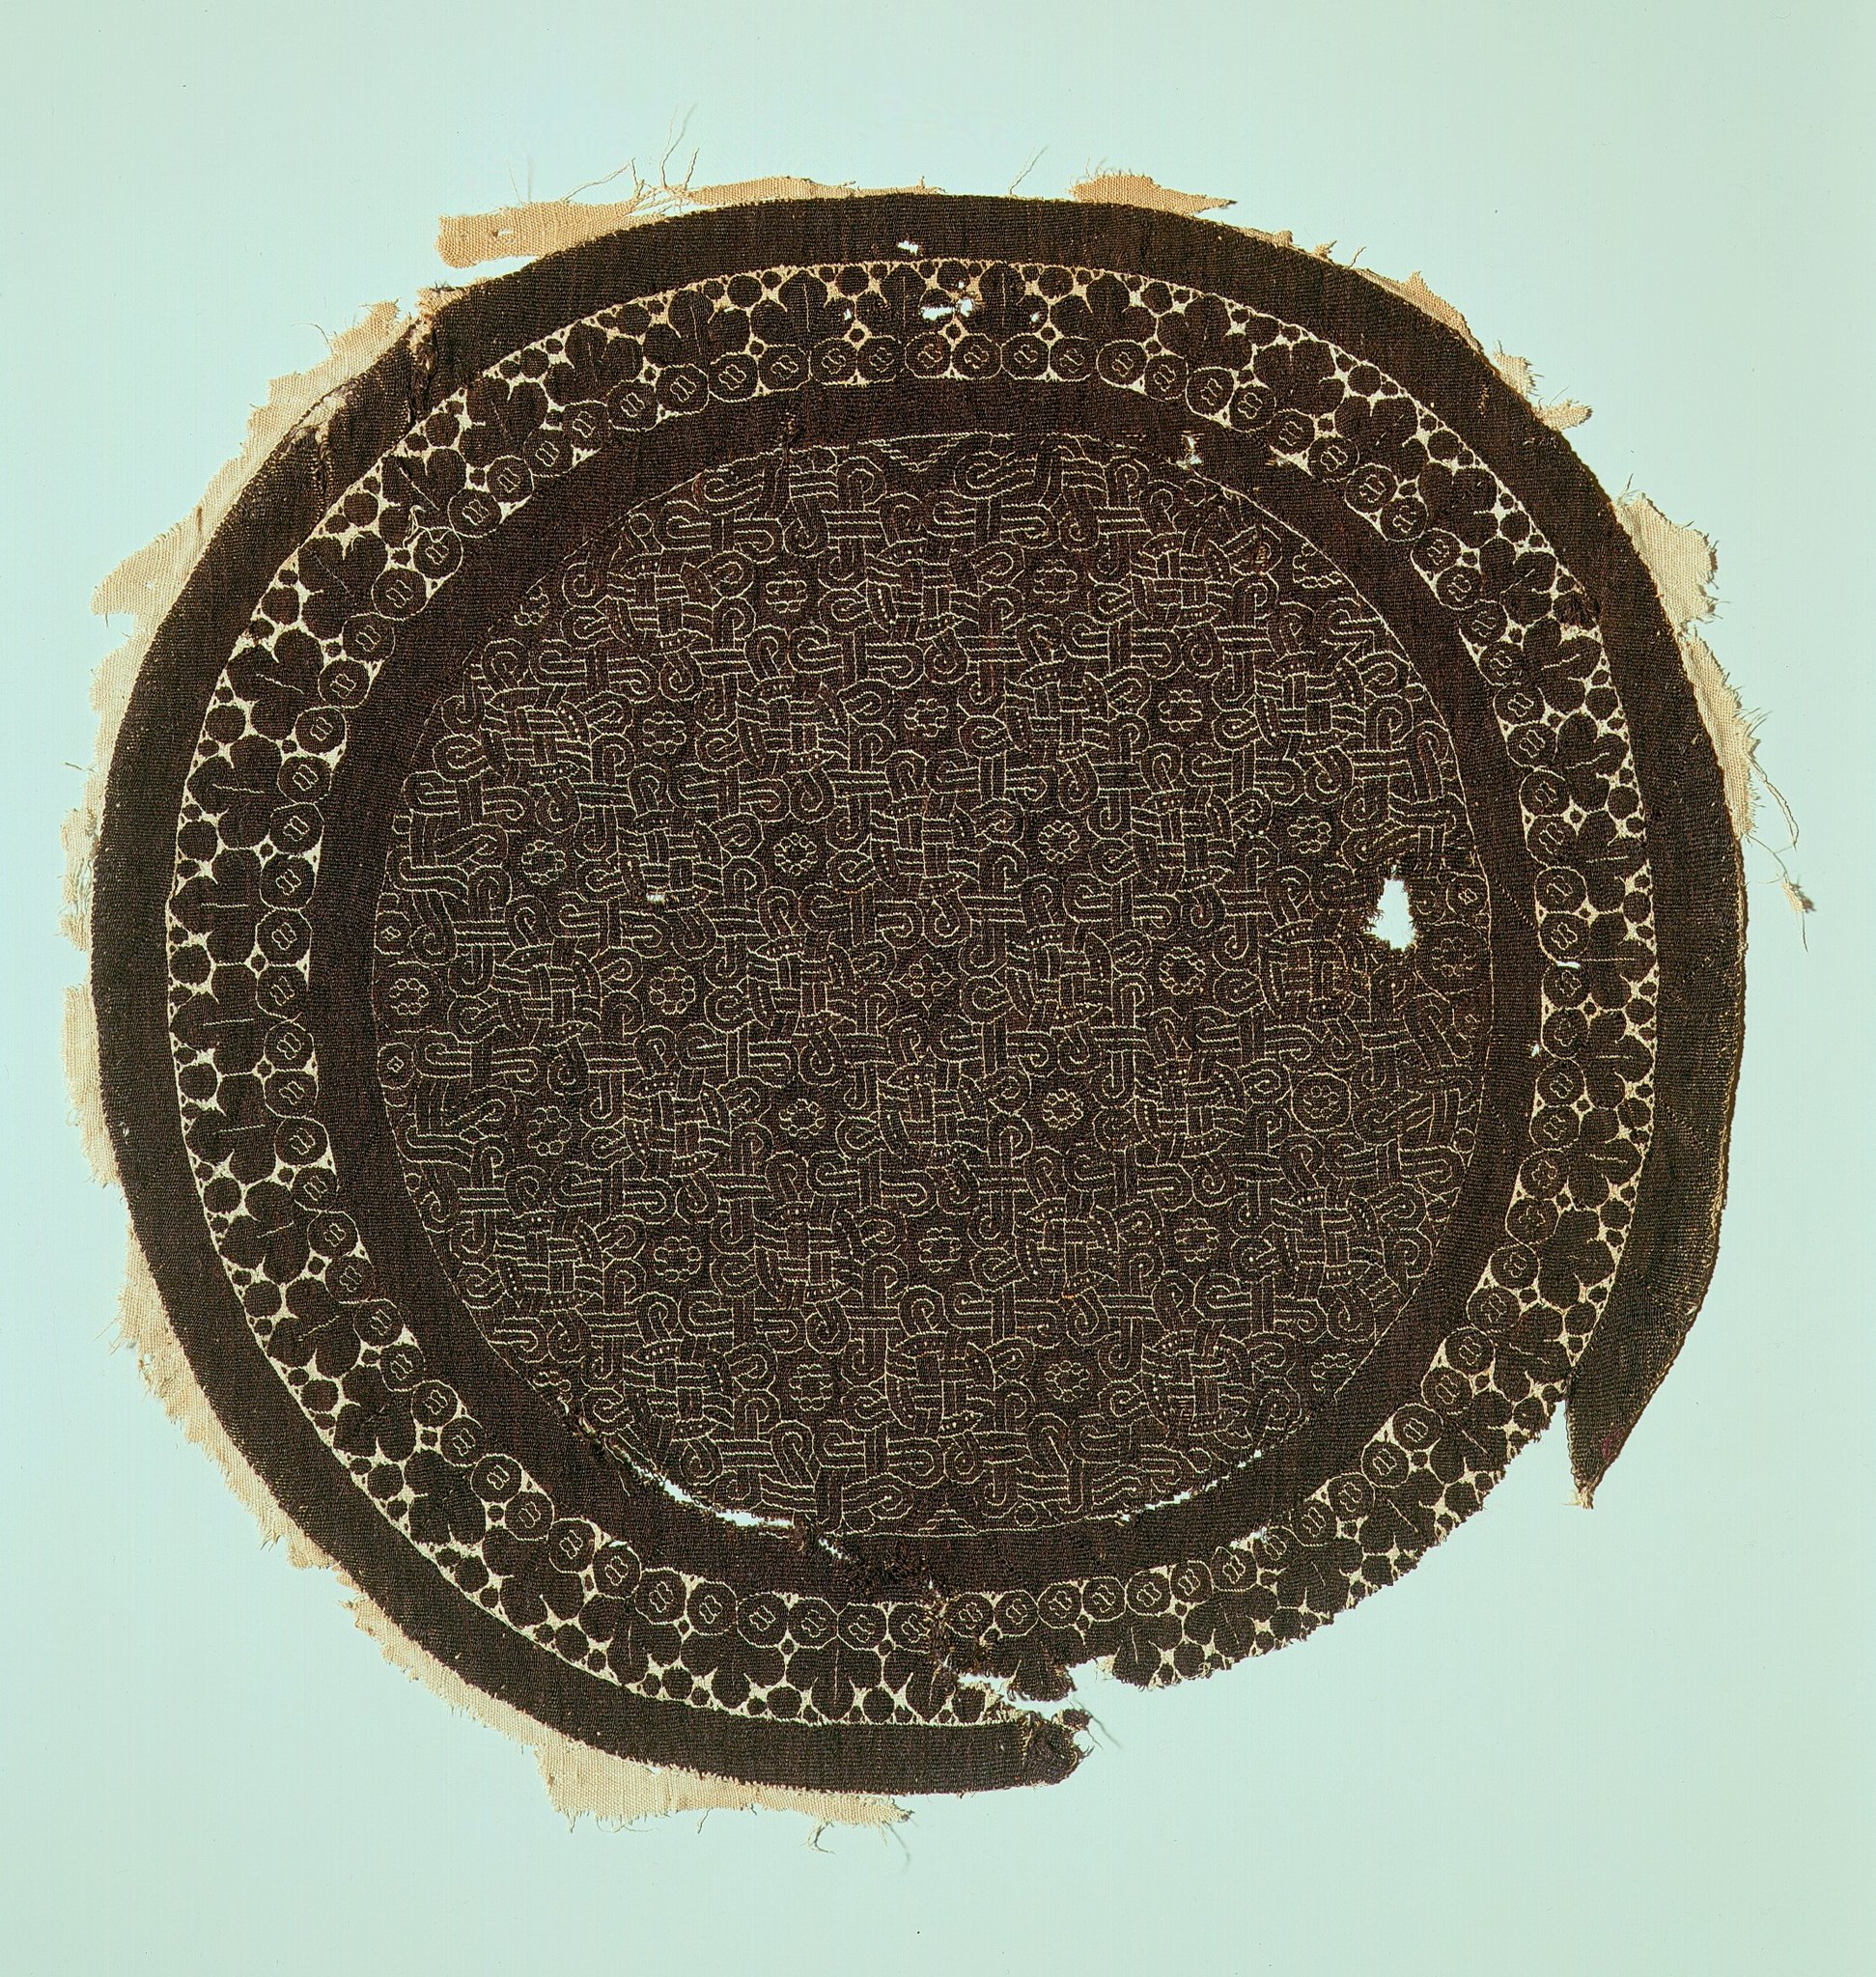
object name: textile fragment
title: Large Interlace Roundel from a Domestic Textile or Tunic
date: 301-400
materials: linen, wool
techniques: weave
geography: egypt